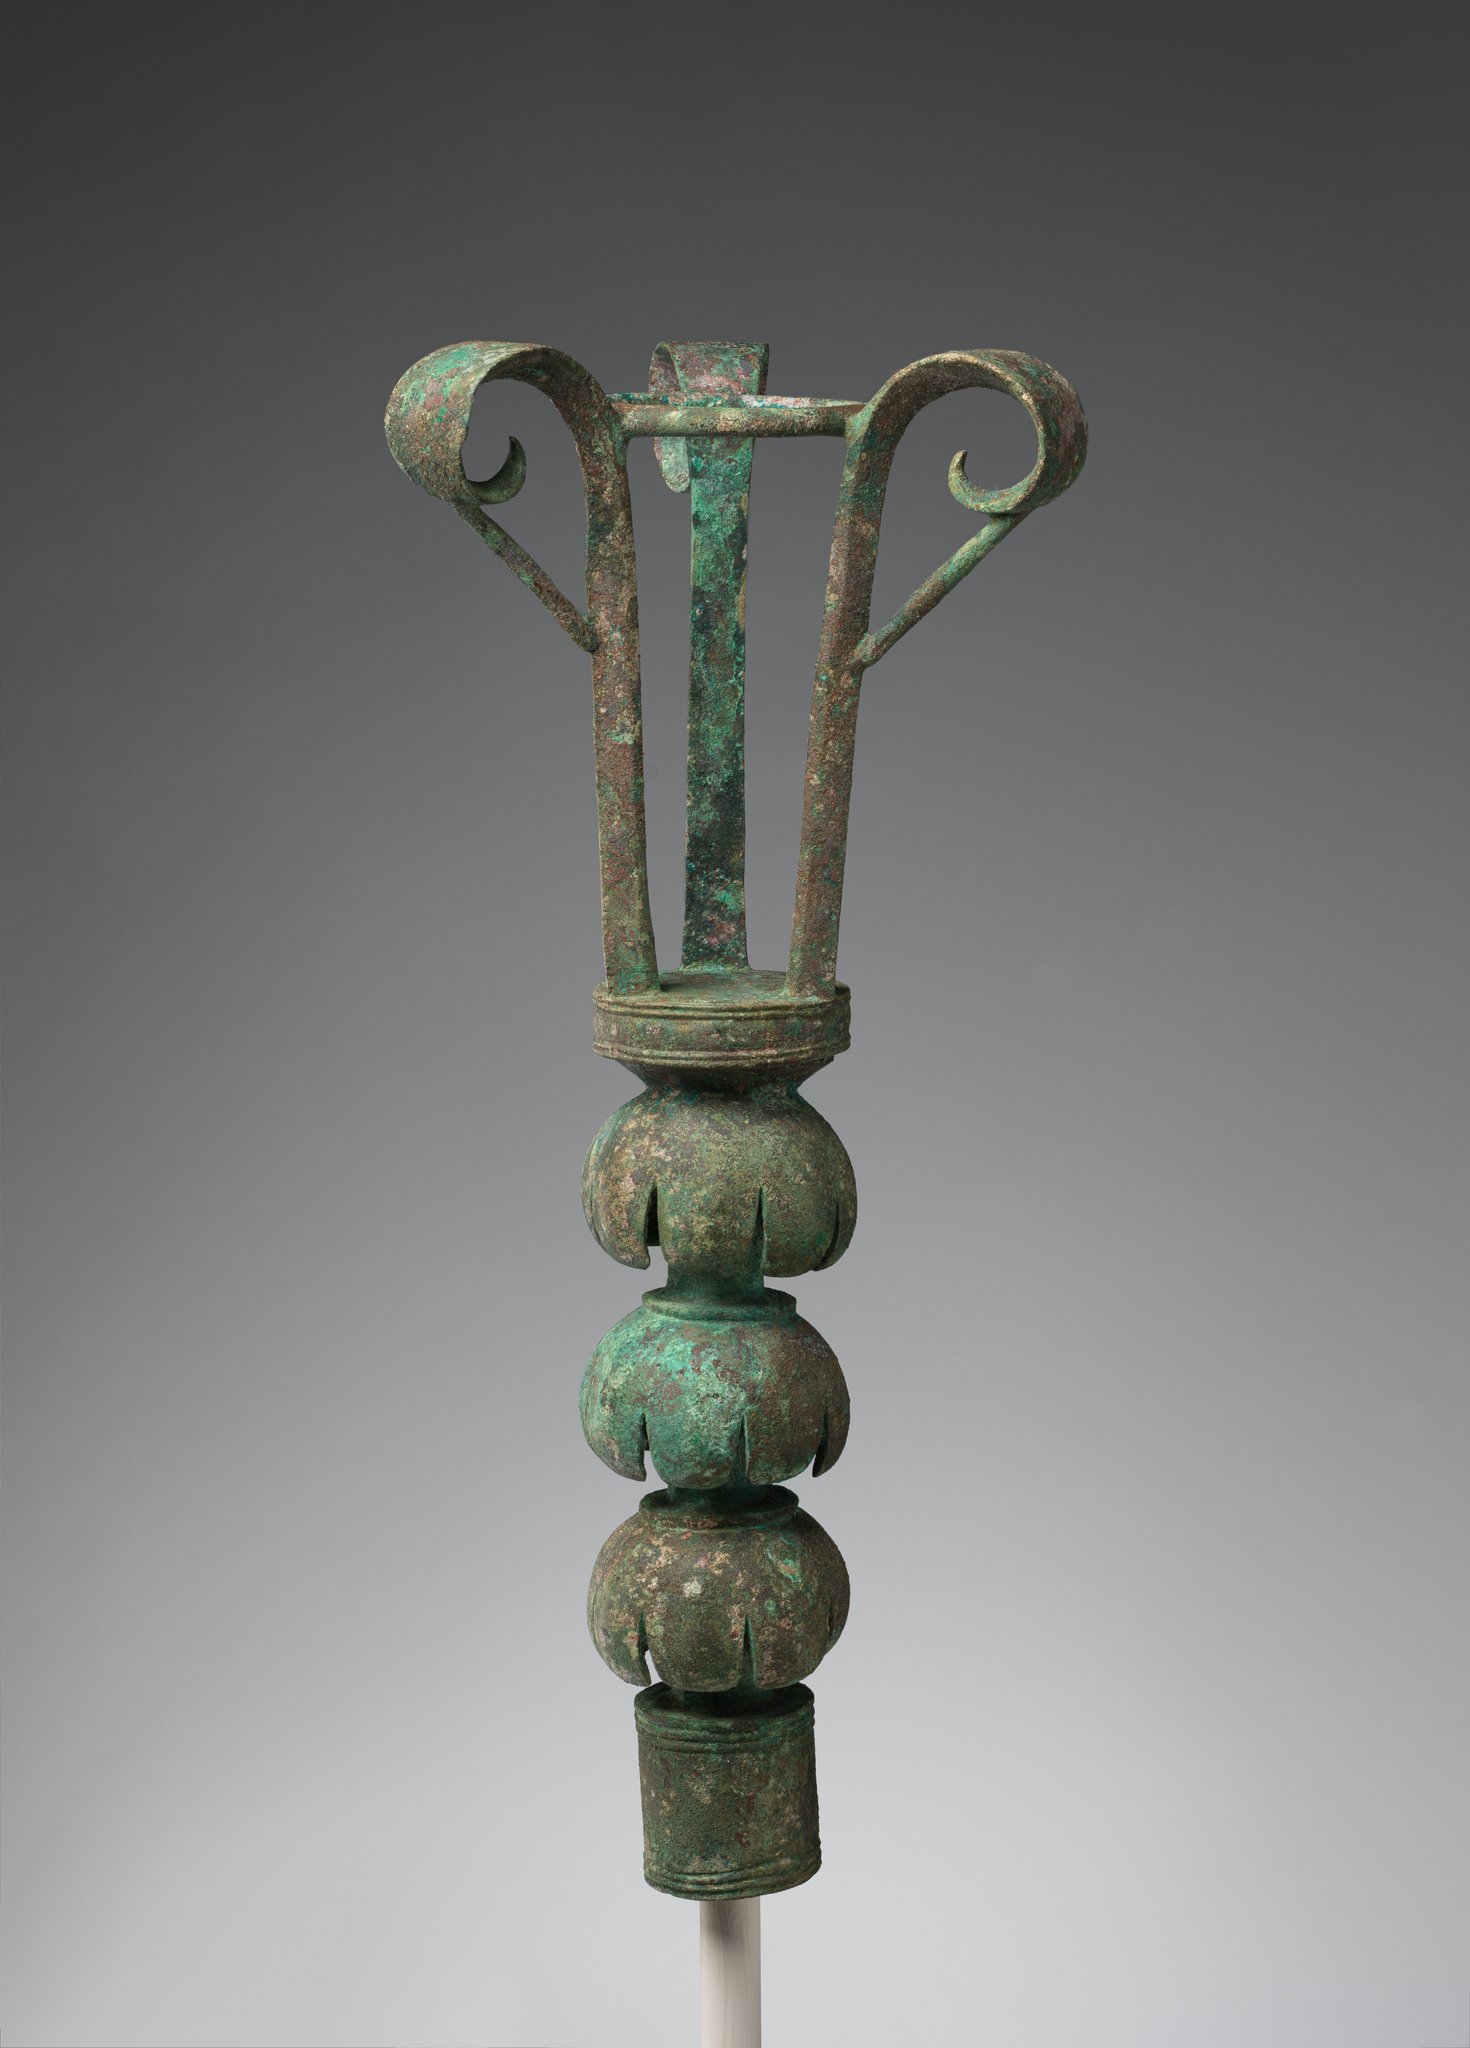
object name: lampstand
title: Bronze lamp holder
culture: cypriot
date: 600-501 BCE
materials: bronze